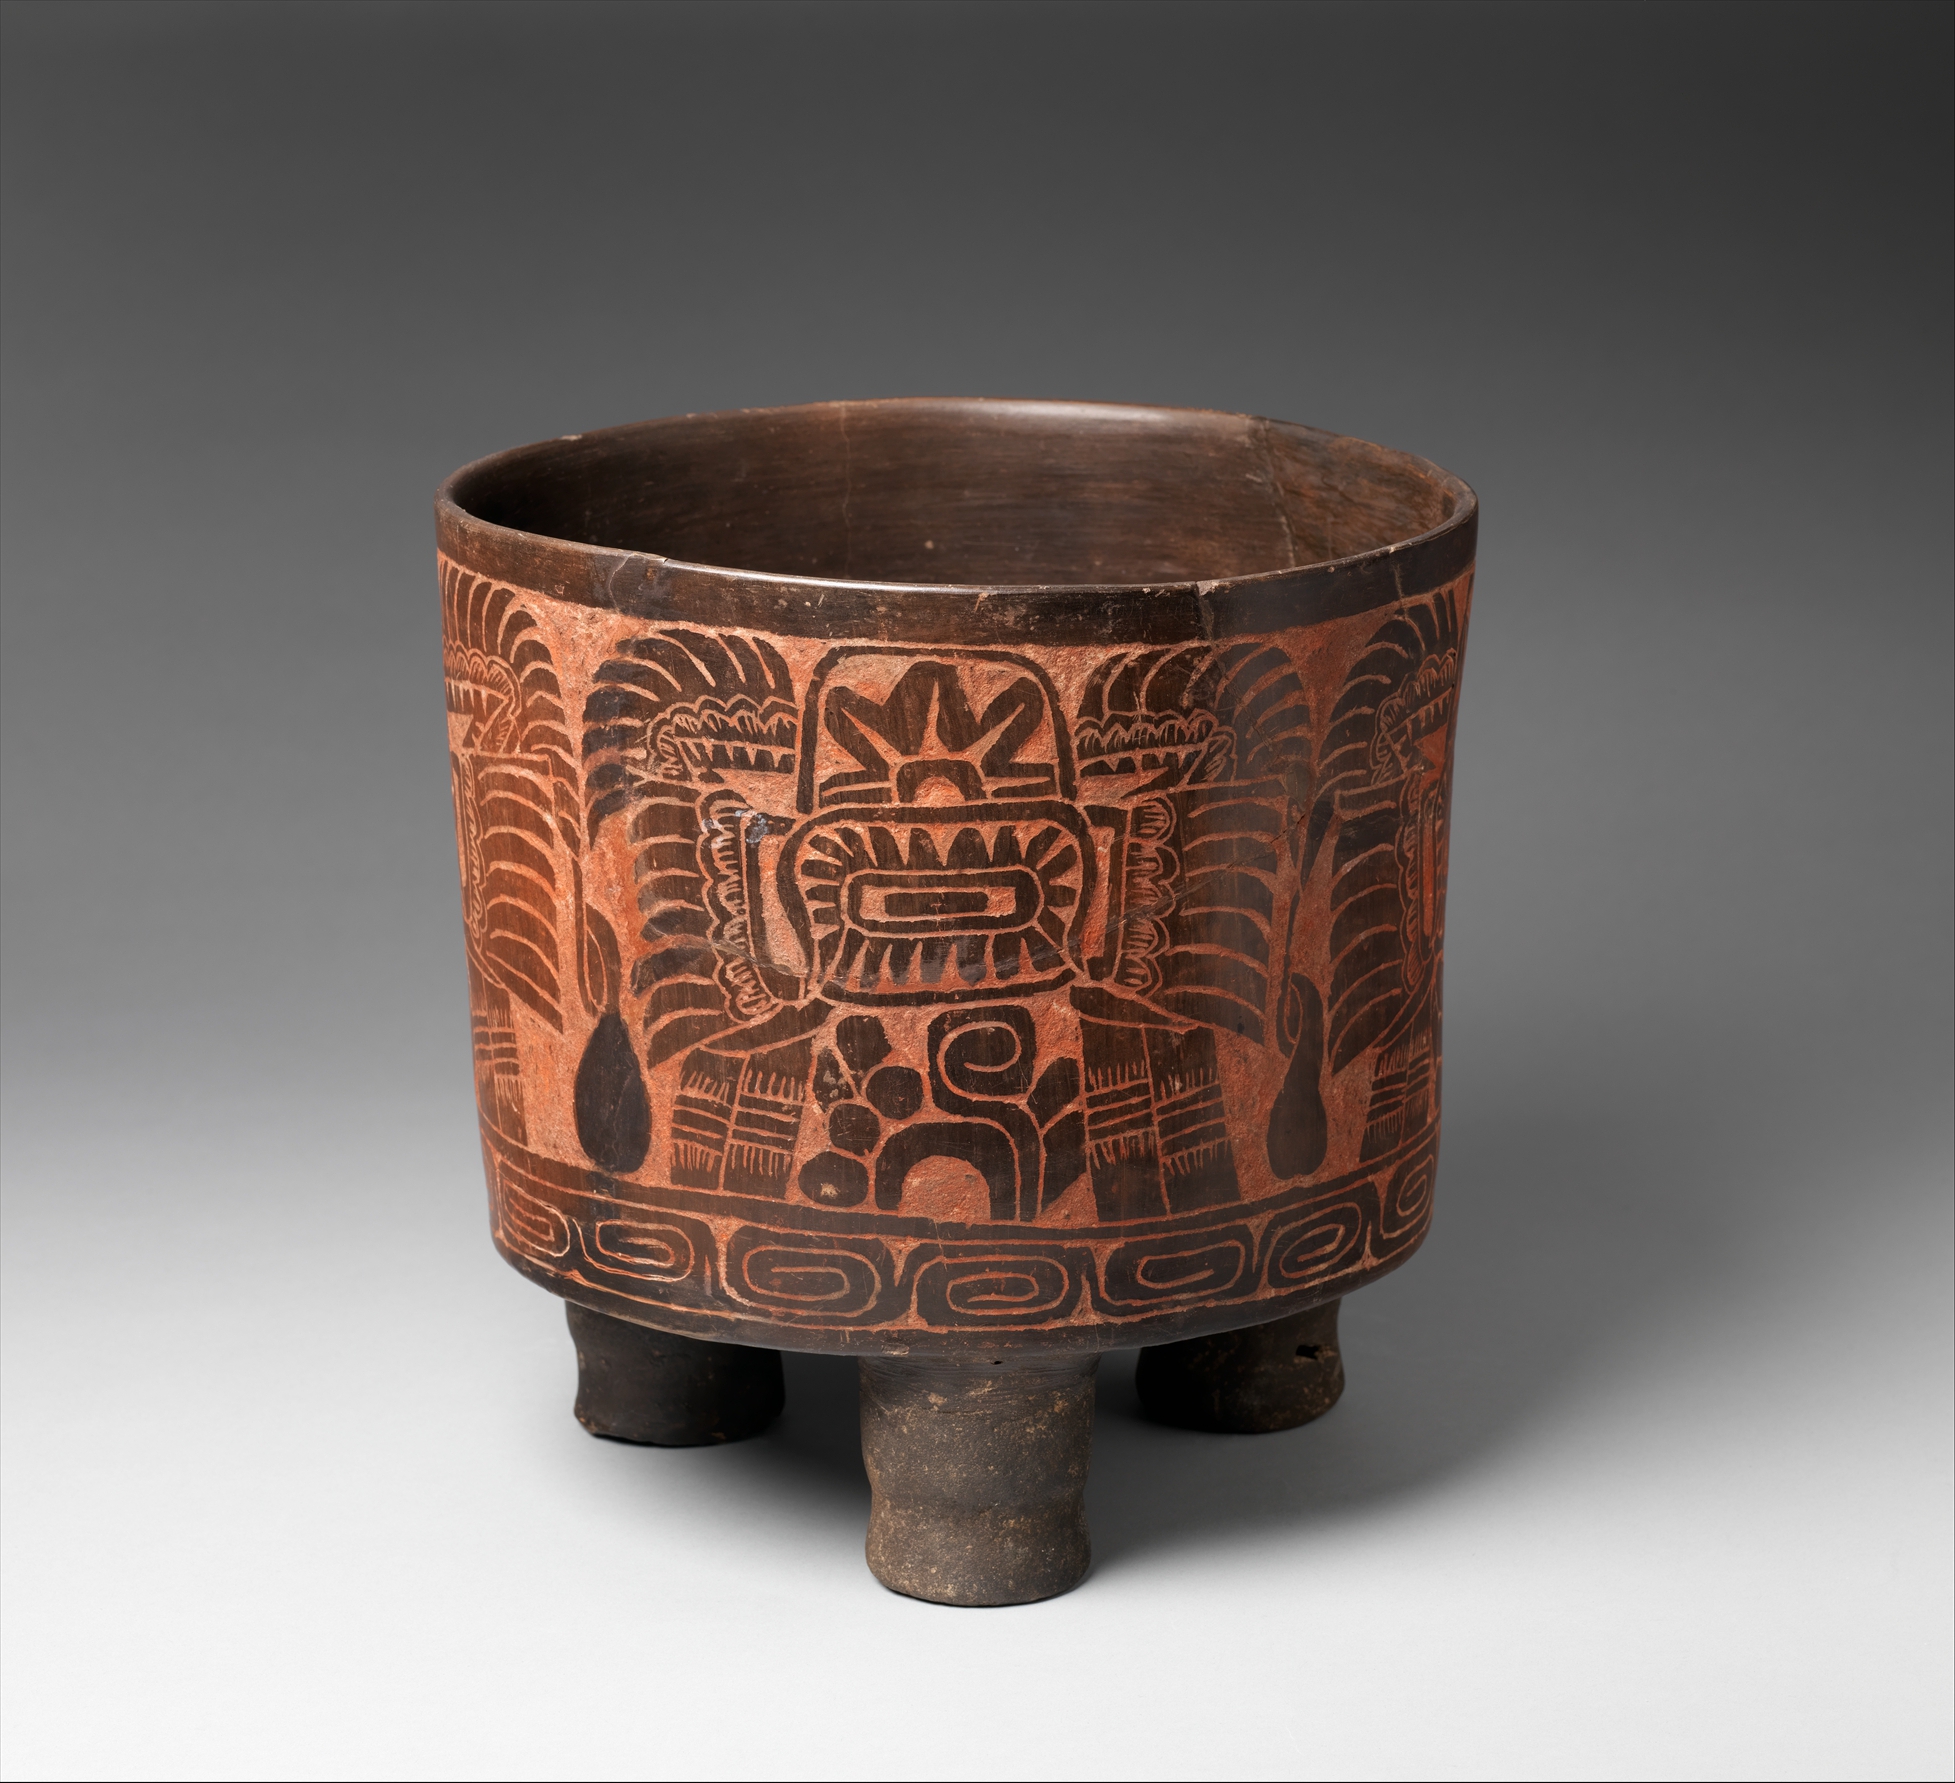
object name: vessel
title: Tripod vessel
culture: teotihuacan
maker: teotihuacan artist(s)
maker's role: artist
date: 350-450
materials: ceramic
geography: mexico